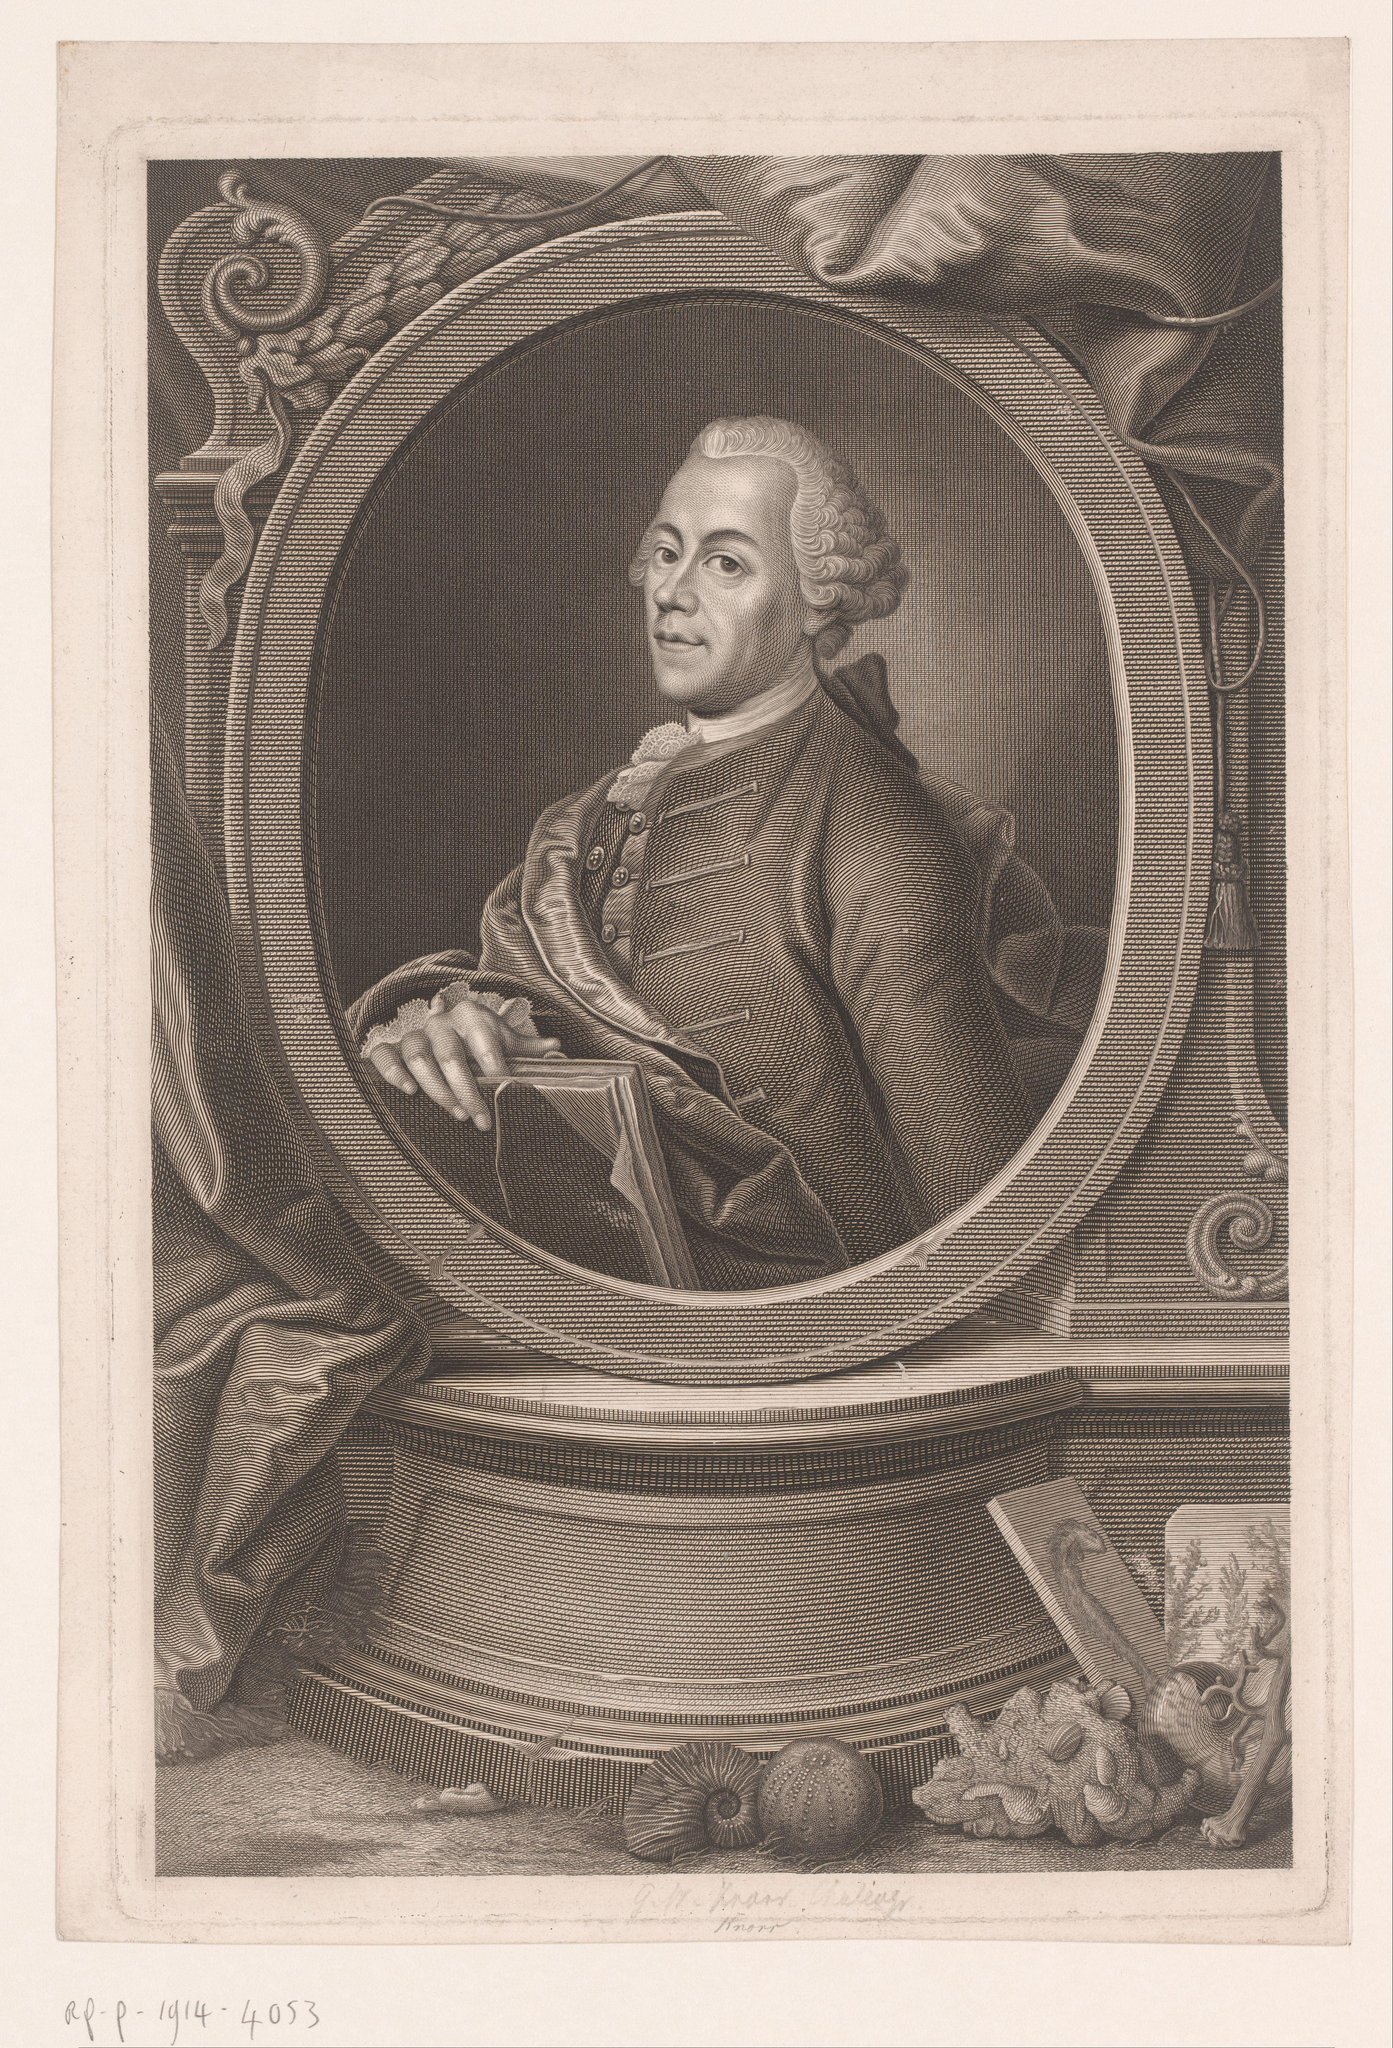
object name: print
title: Portret van Georg Wolfgang Knorr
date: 1761-1787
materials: paper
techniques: engraving, etching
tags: georg wolfgang knorr, coelenterata, rock types of animal or plant origin, historical persons, molluscs